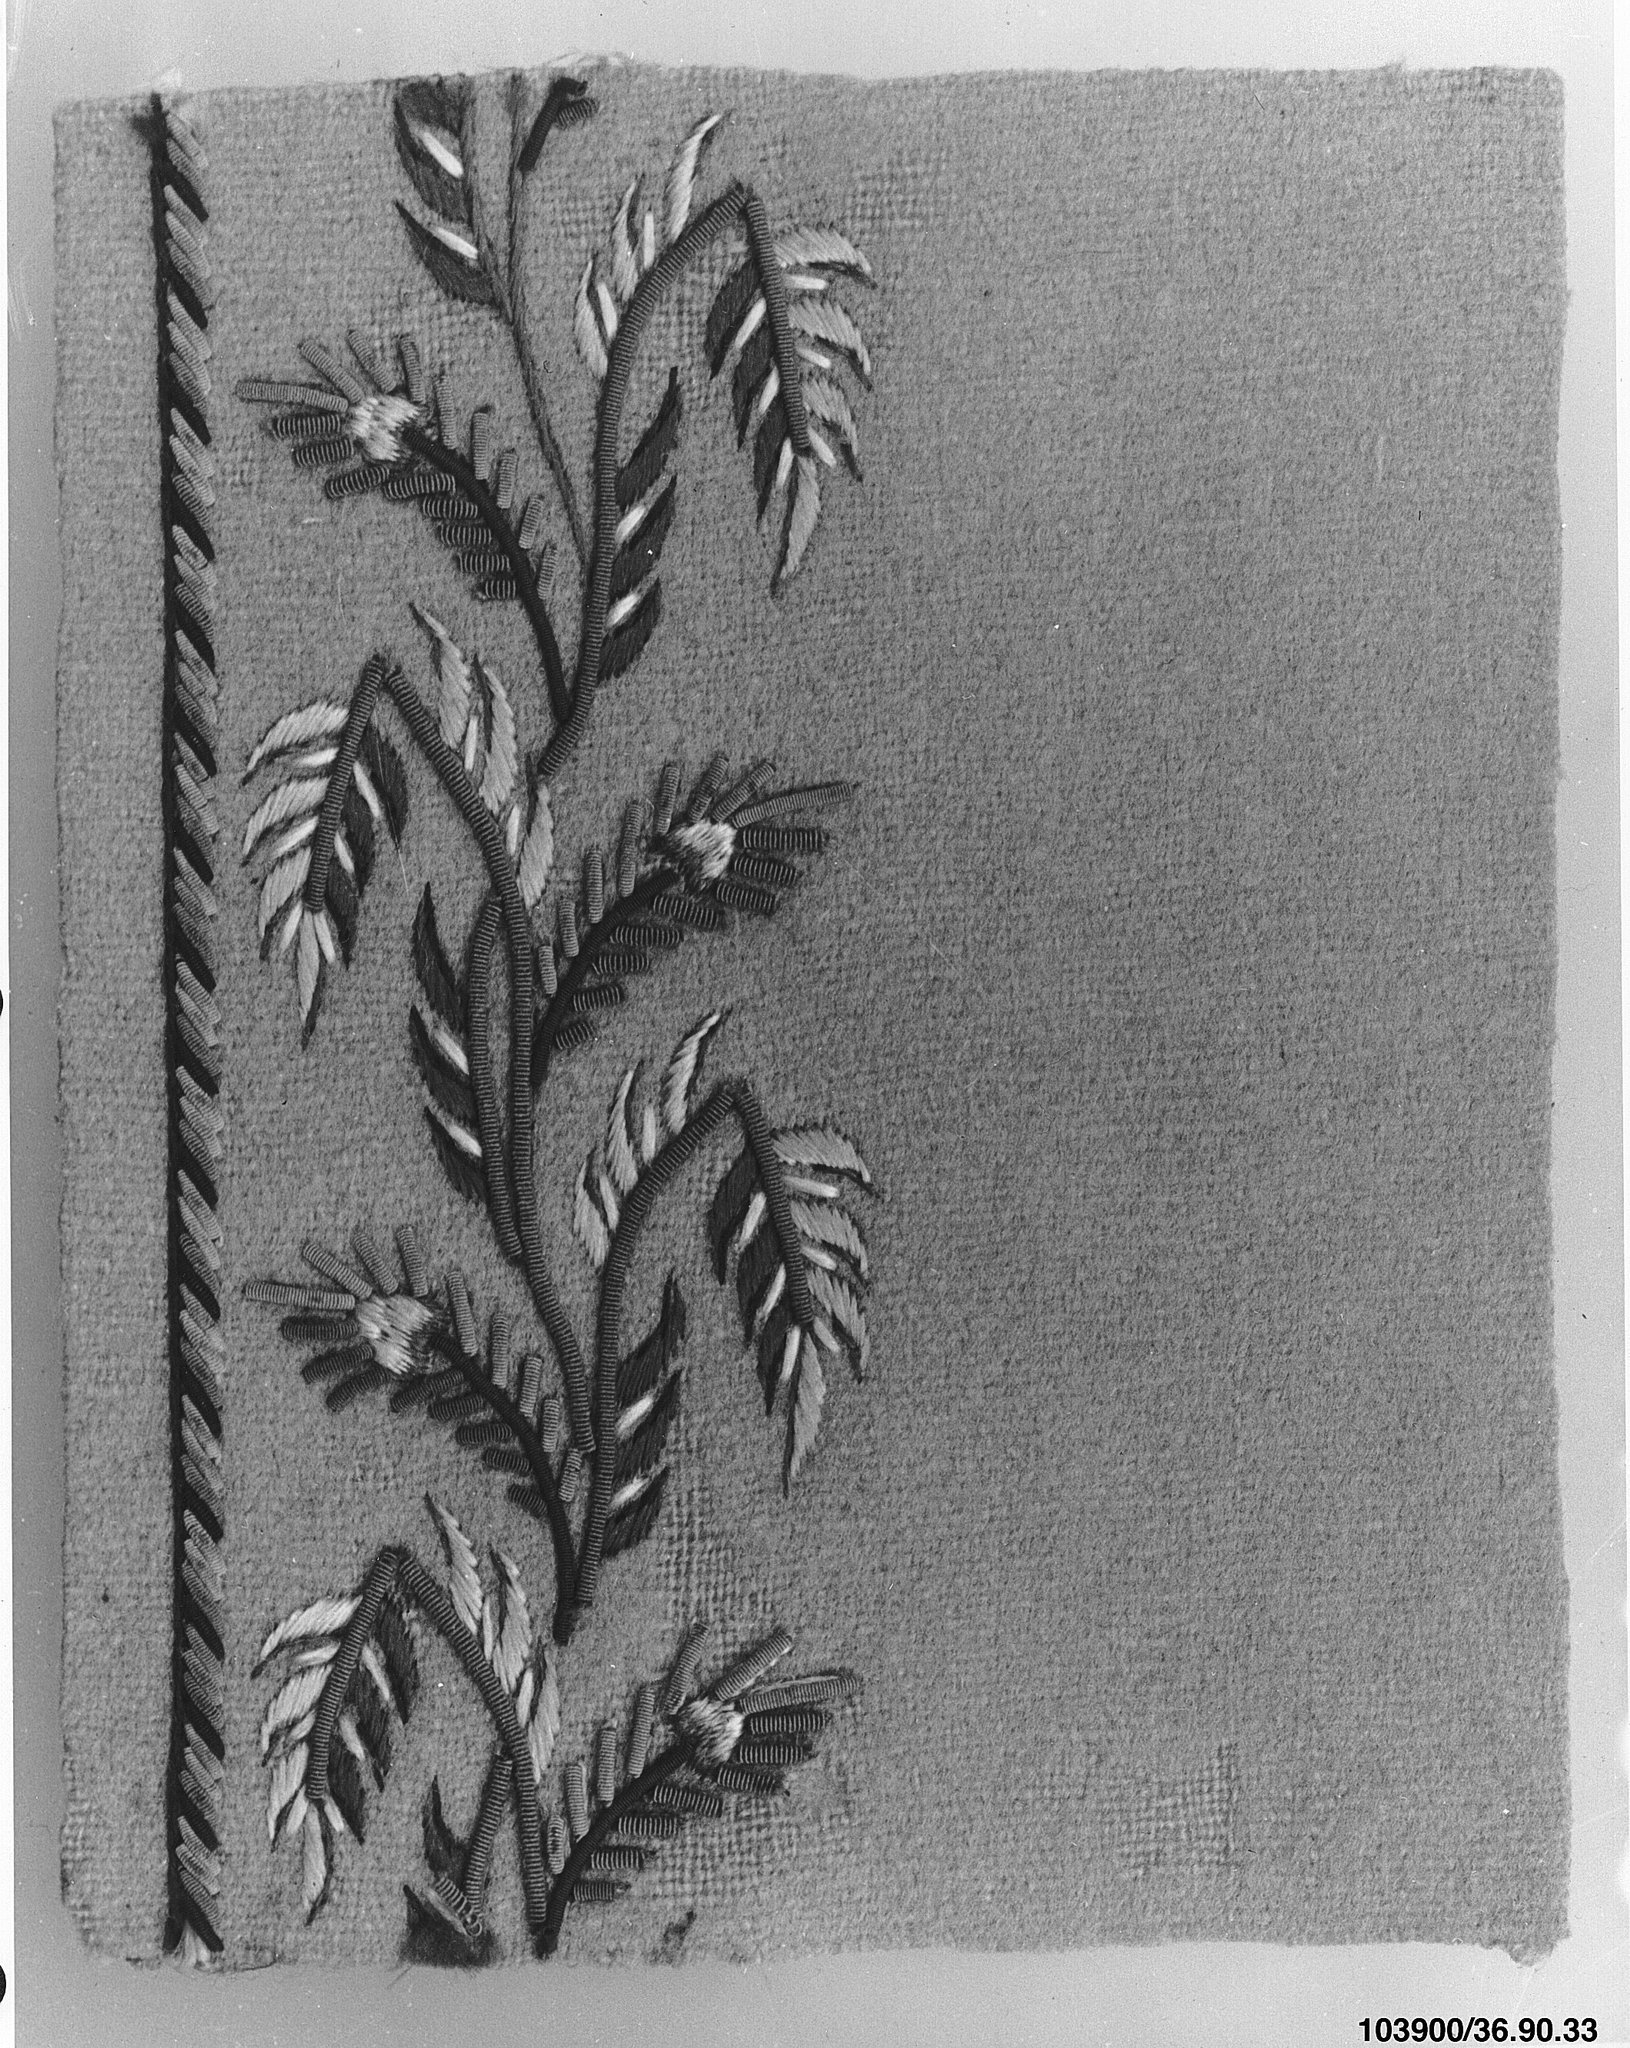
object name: sample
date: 1801-1833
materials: metal thread, silk, wool